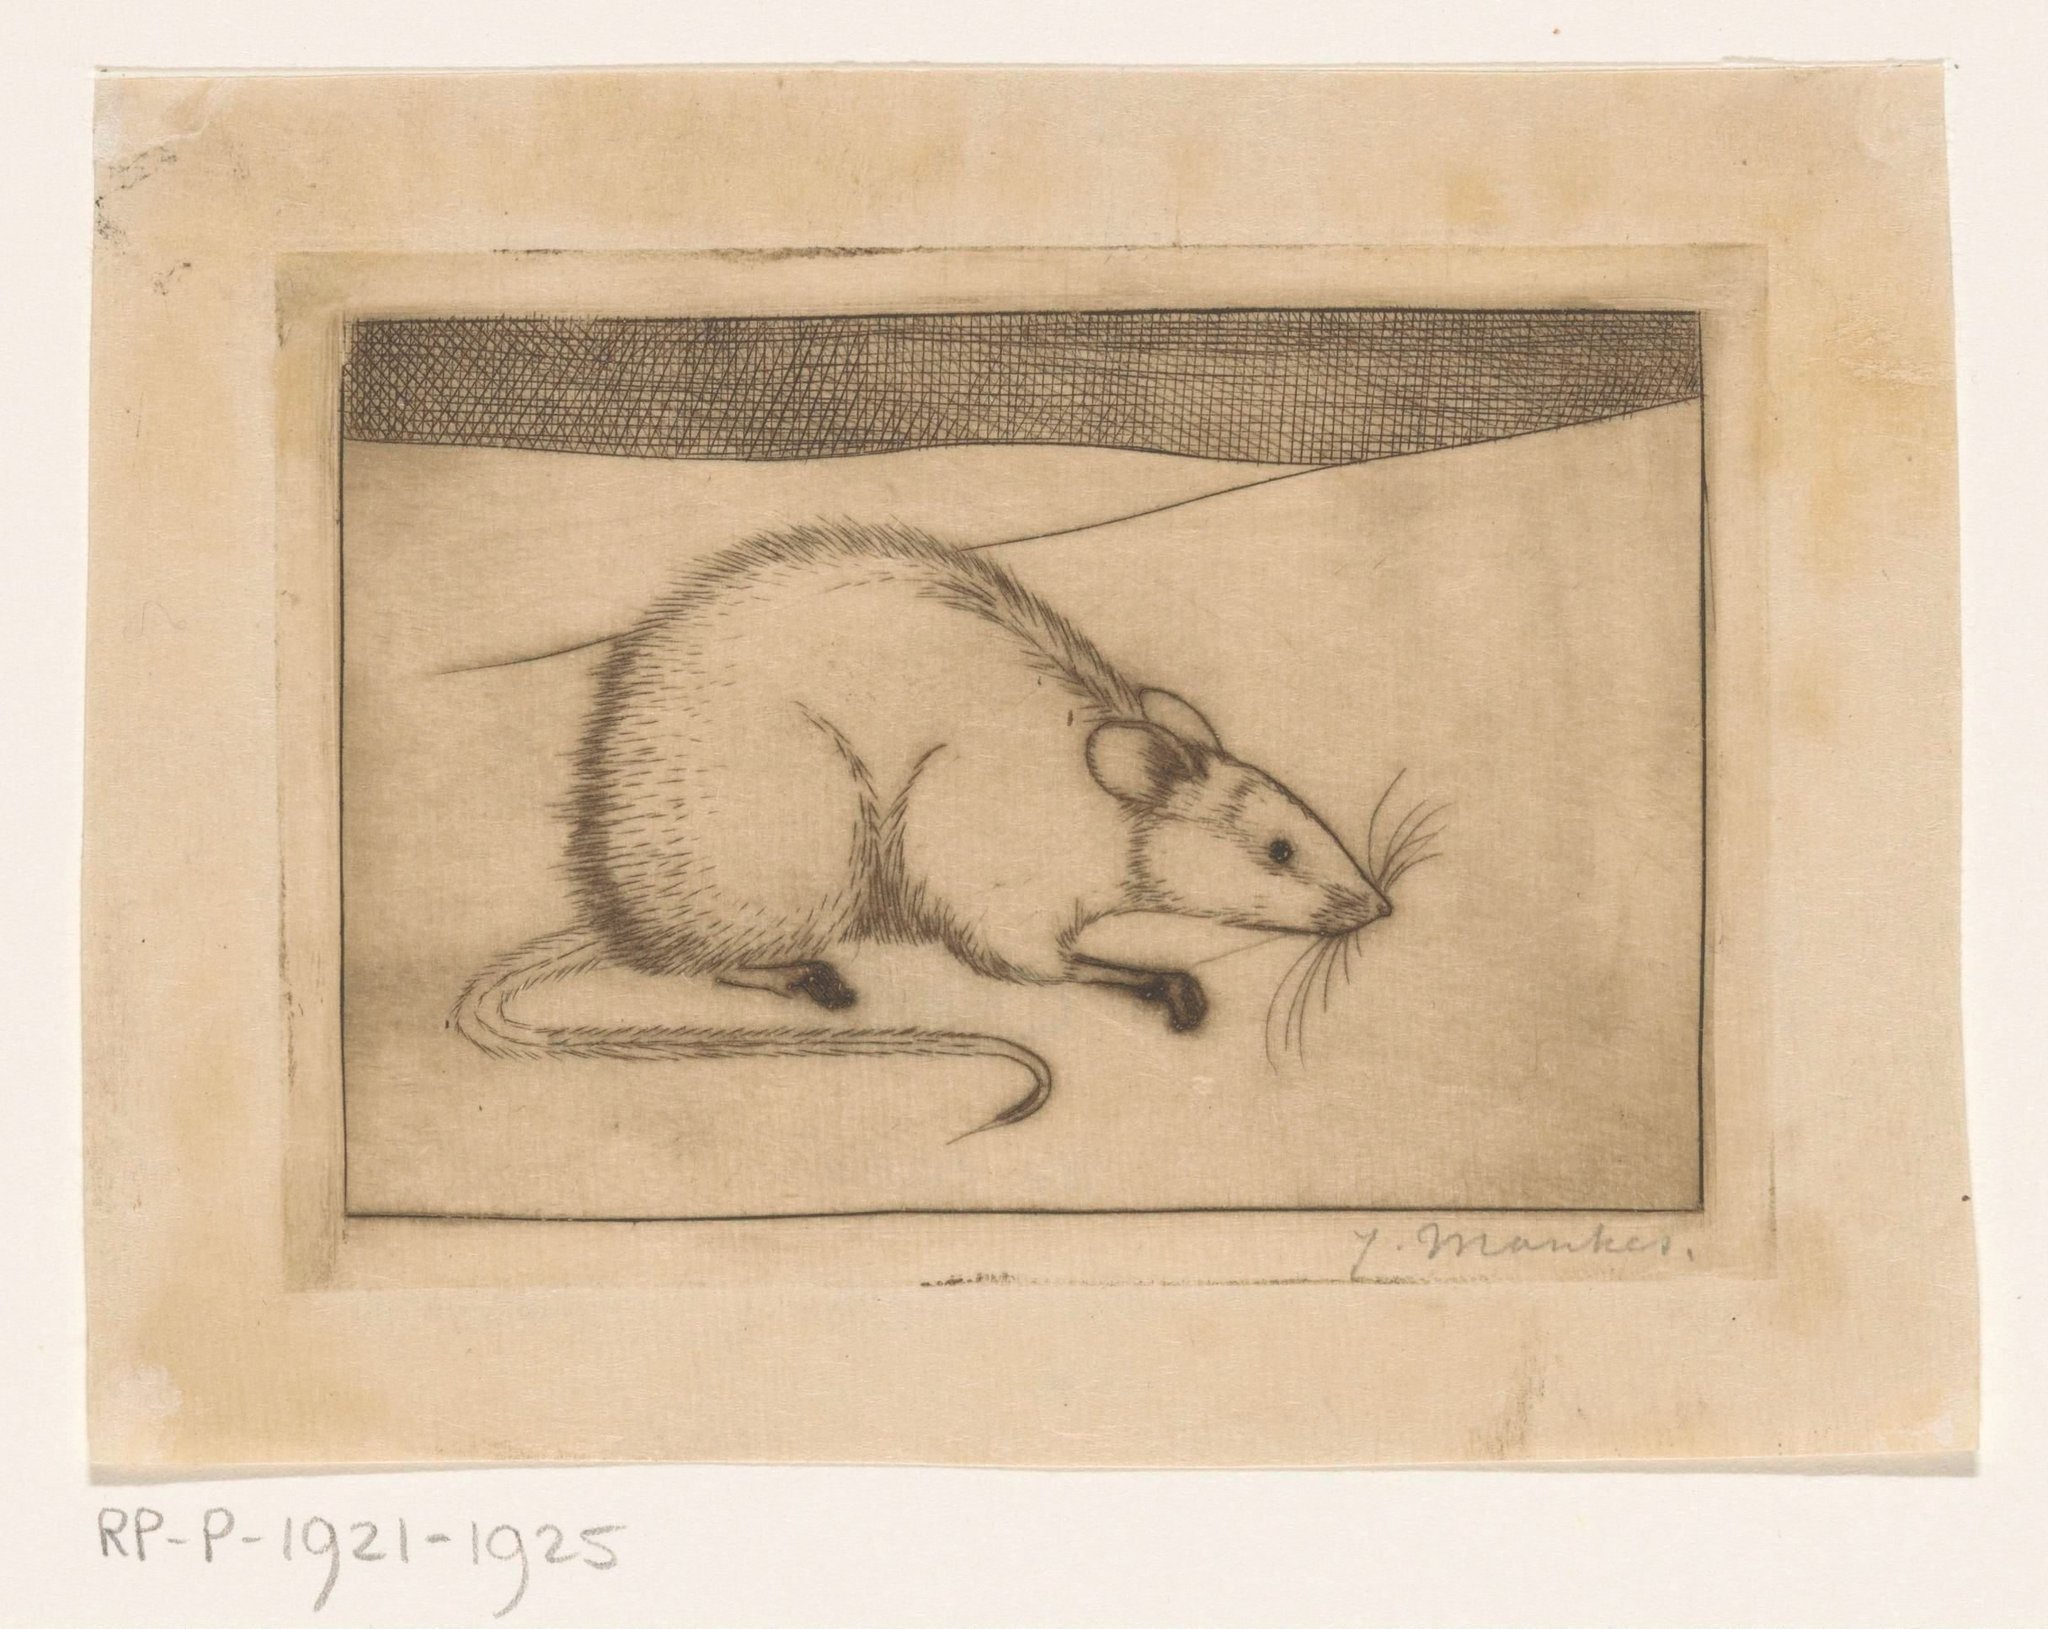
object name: print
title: Muis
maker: jan mankes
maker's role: draughtsman, painter, print maker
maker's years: 1889-1920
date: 1916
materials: paper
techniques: engraving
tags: rodents: mouse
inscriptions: collector's mark: Lugt 2228